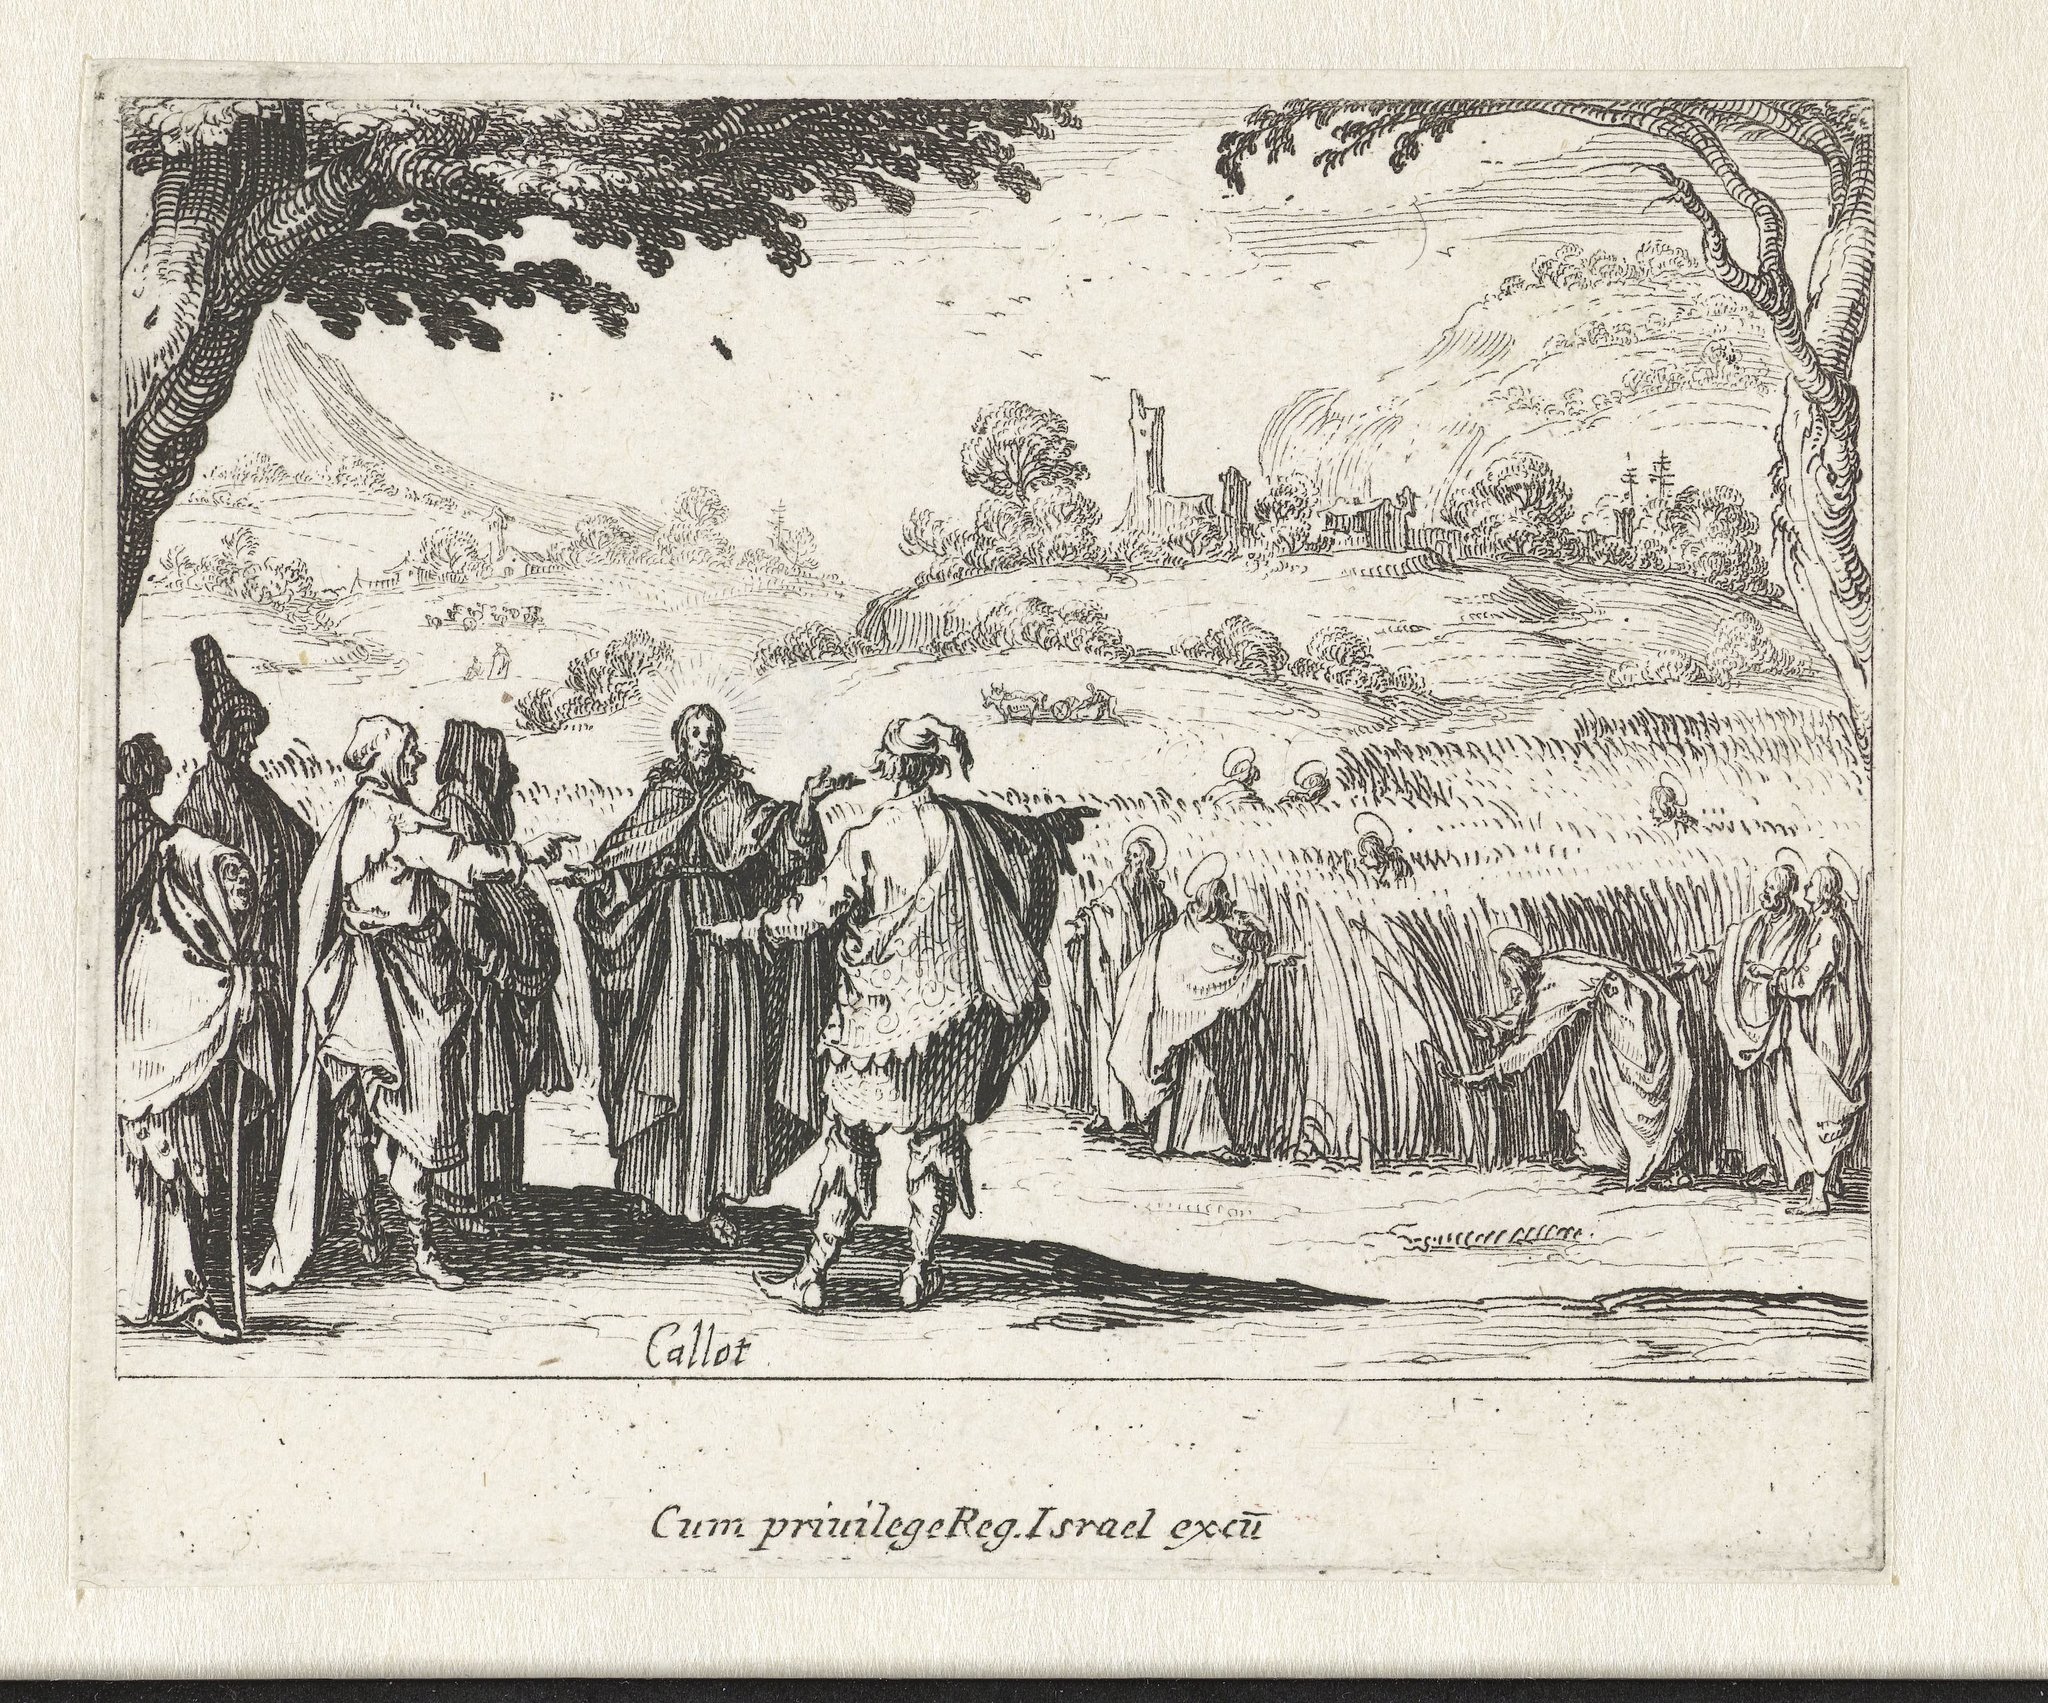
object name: print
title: Christus discussieert met farizeeërs over het plukken van aren op sabbat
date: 1635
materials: paper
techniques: etching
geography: paris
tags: discussion with pharisees about the plucking of corn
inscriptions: collector's mark: Lugt 240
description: Christus voert een discussie met enkele farizeeërs, terwijl achter hem zijn discipelen aren plukken in een graanveld. Deze prent is onderdeel van een reeks van tien prenten met voorstellingen uit het Nieuwe Testament, waaraan na Callots dood een titelprent is toegevoegd.